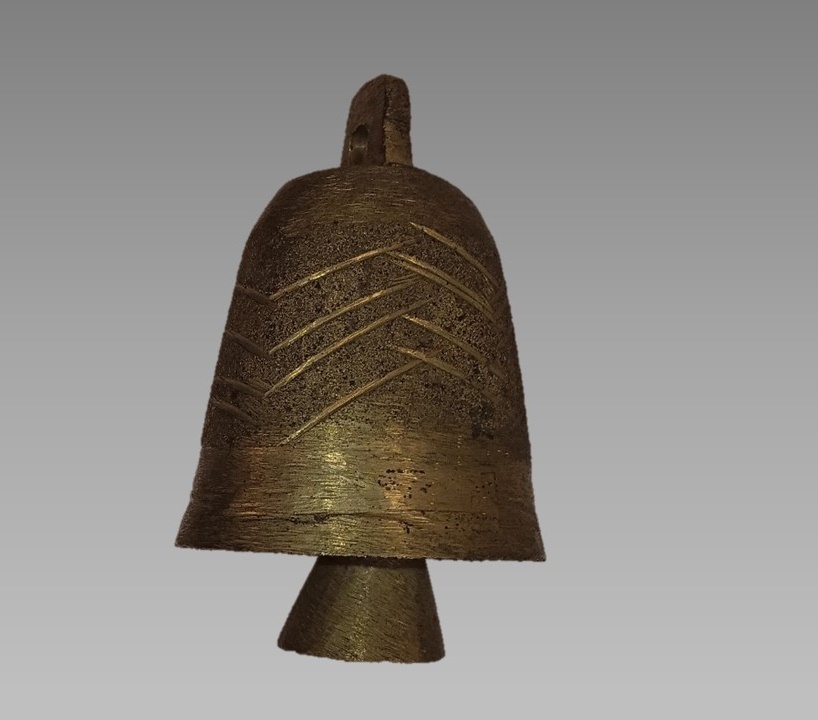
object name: zanguleh zangula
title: Zanguleh (zangula)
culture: iranian or persian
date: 1850-1889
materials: metal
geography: iran